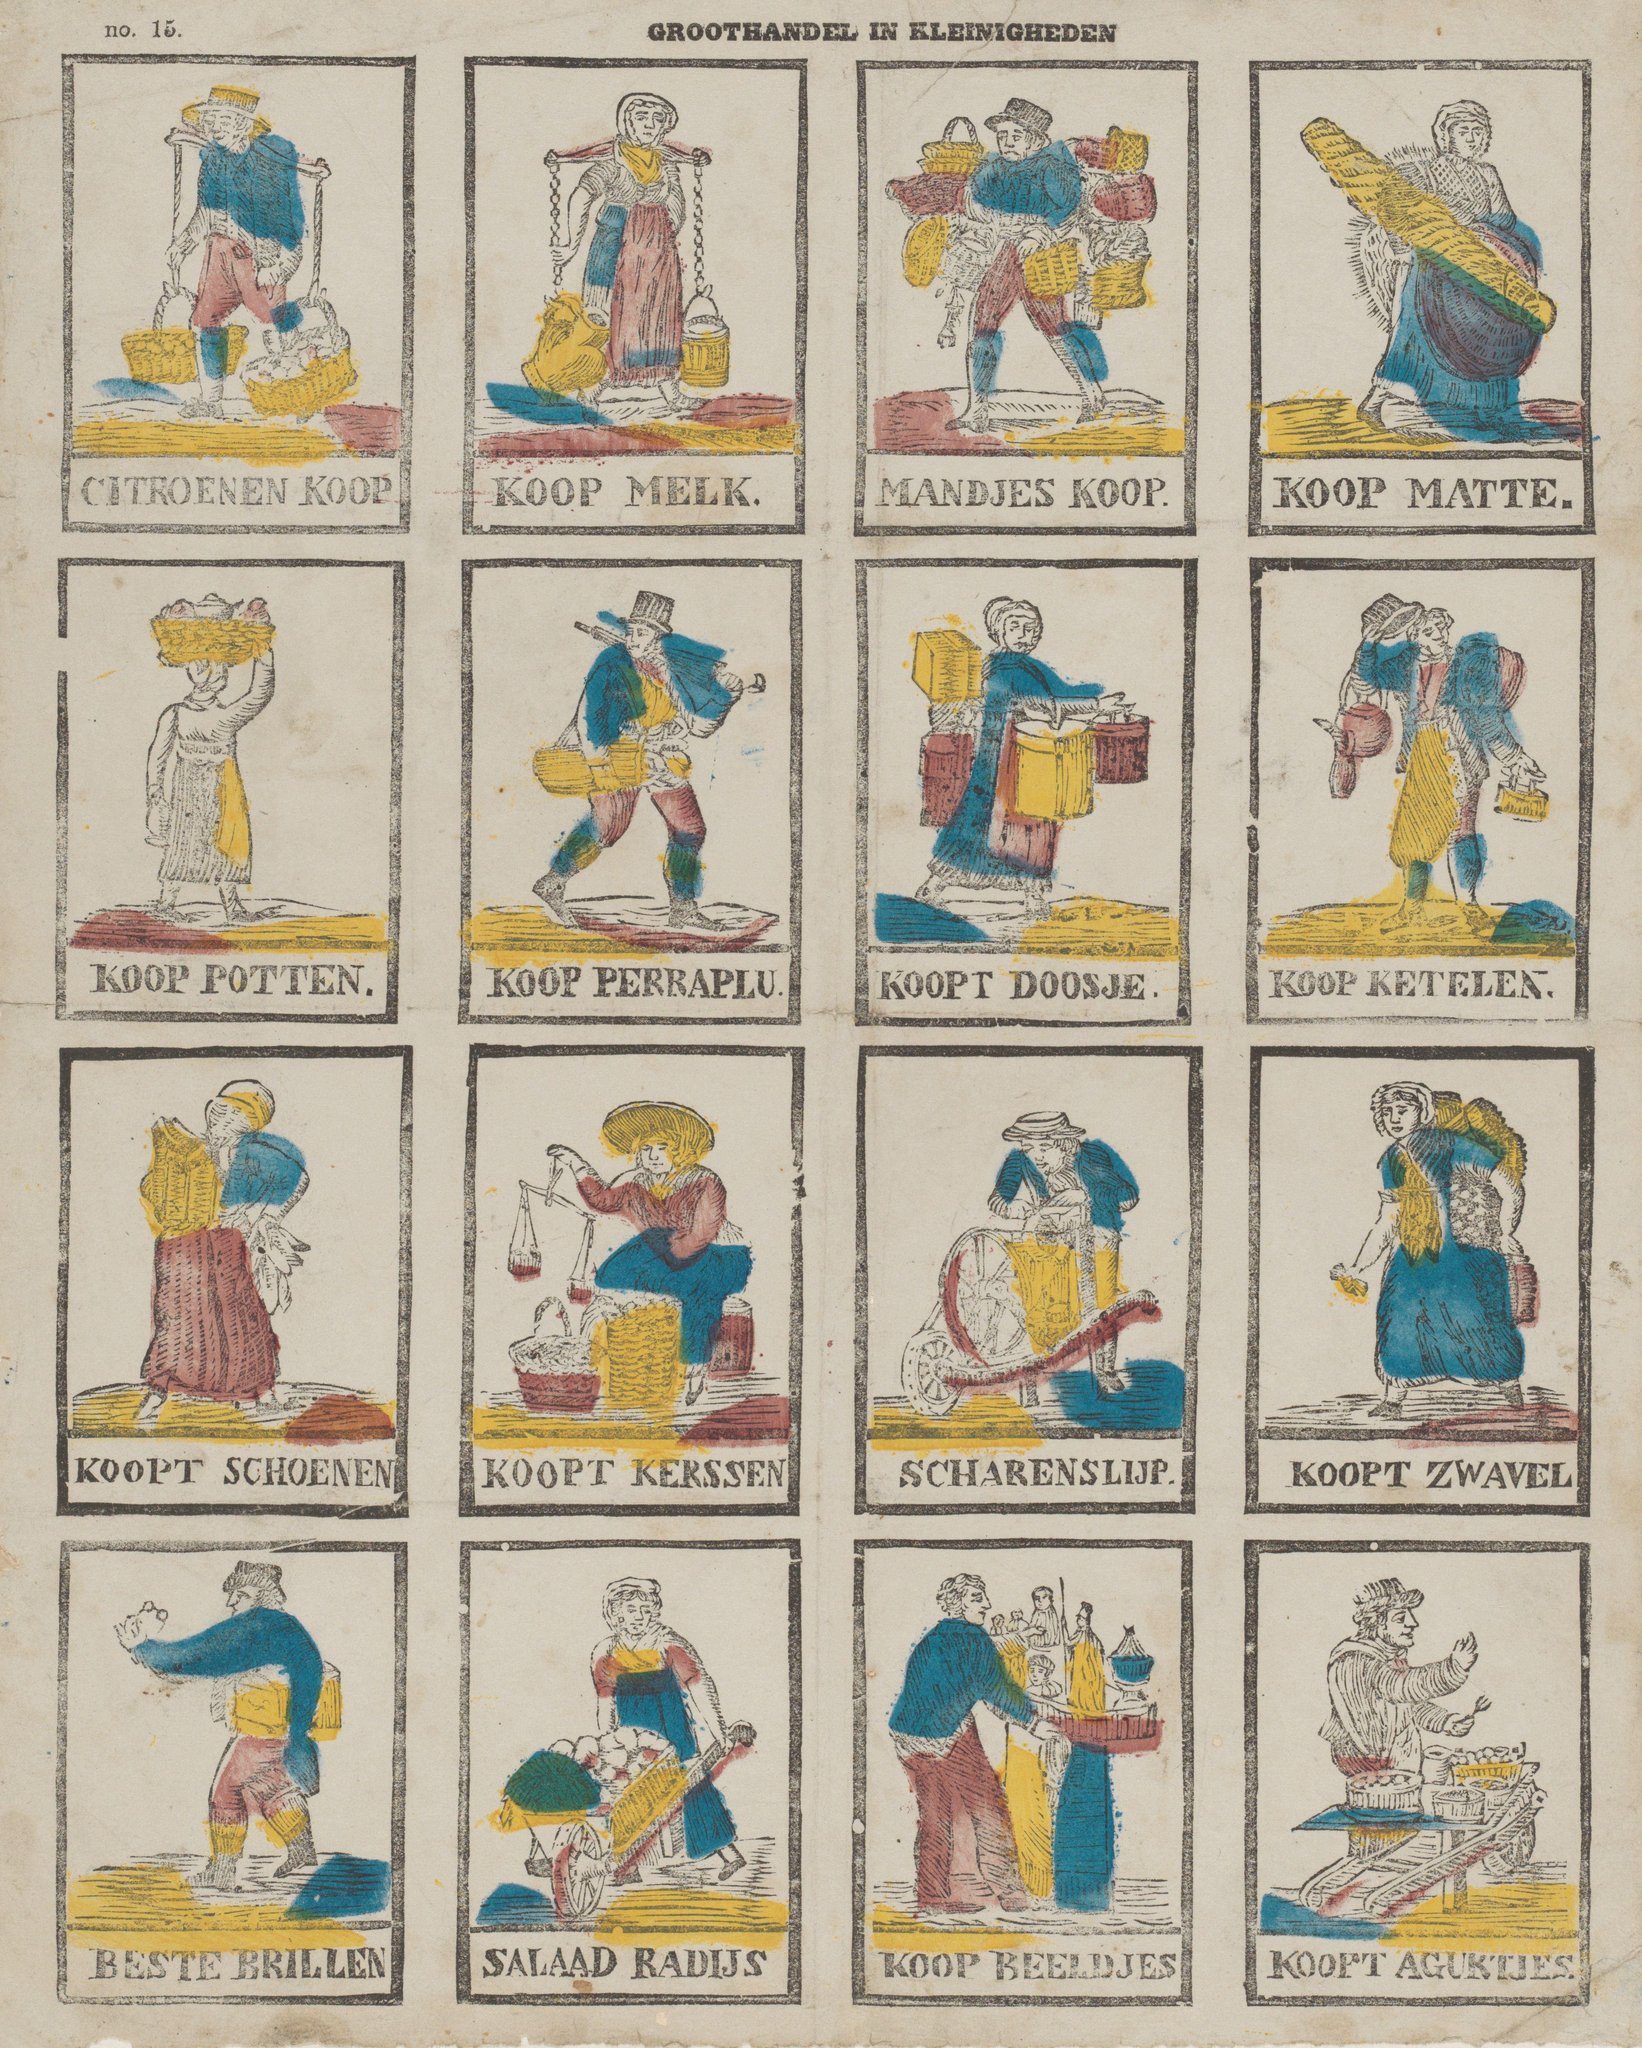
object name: popular print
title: Groothandel in kleinigheden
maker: Anonymous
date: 1848-1881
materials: paper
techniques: colour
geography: netherlands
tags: street-trader, merchant, salesman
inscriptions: collector's mark: Lugt 2760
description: Blad met 16 voorstellingen van straatverkopers. Onder elke afbeelding een onderschrift. Genummerd linksboven: no. 15.